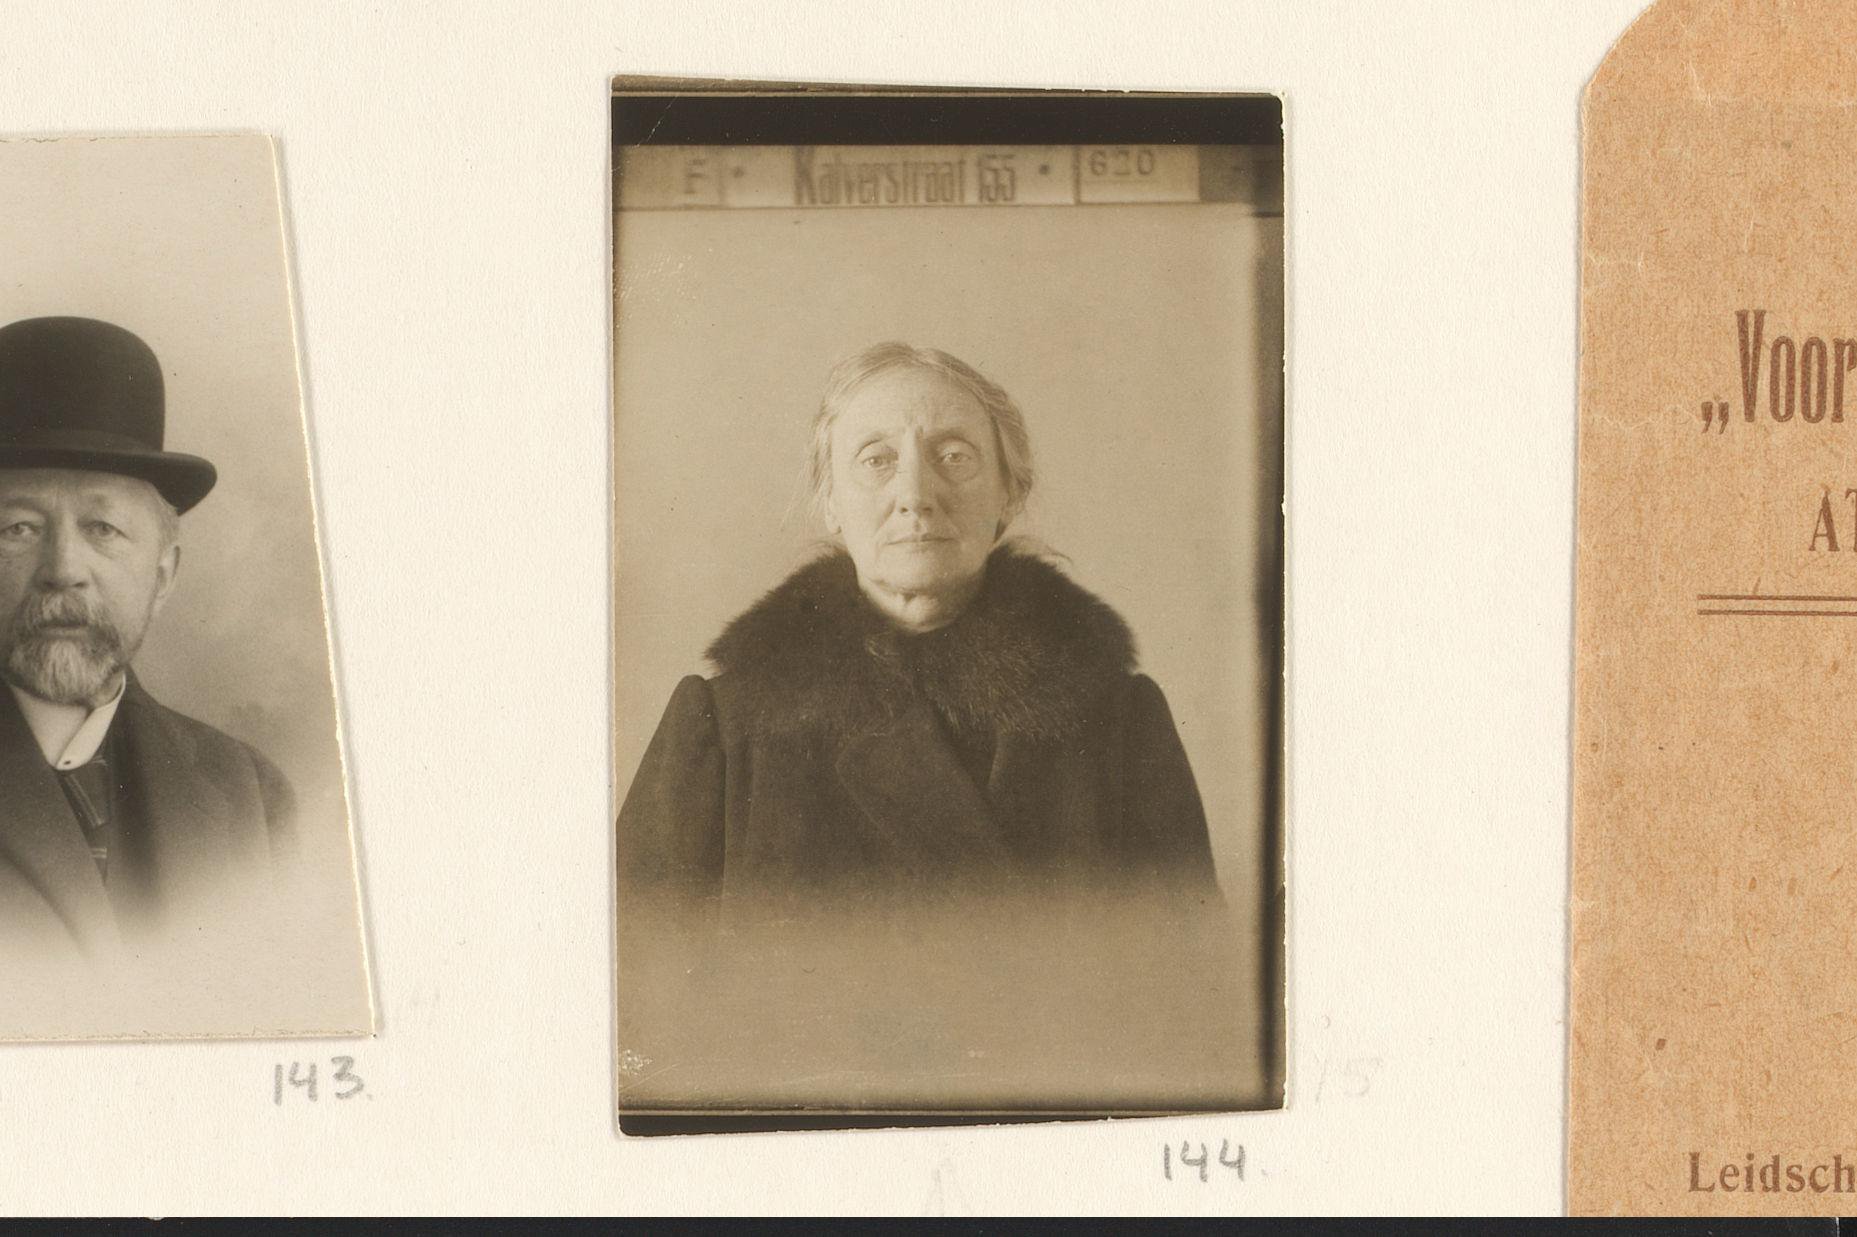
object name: photograph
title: Anne M.L. van der Linden, eerste echtgenote van Andries Bonger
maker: Anonymous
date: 1920-1931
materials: cardboard, paper, photographic support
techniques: gelatin silver print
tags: historical persons